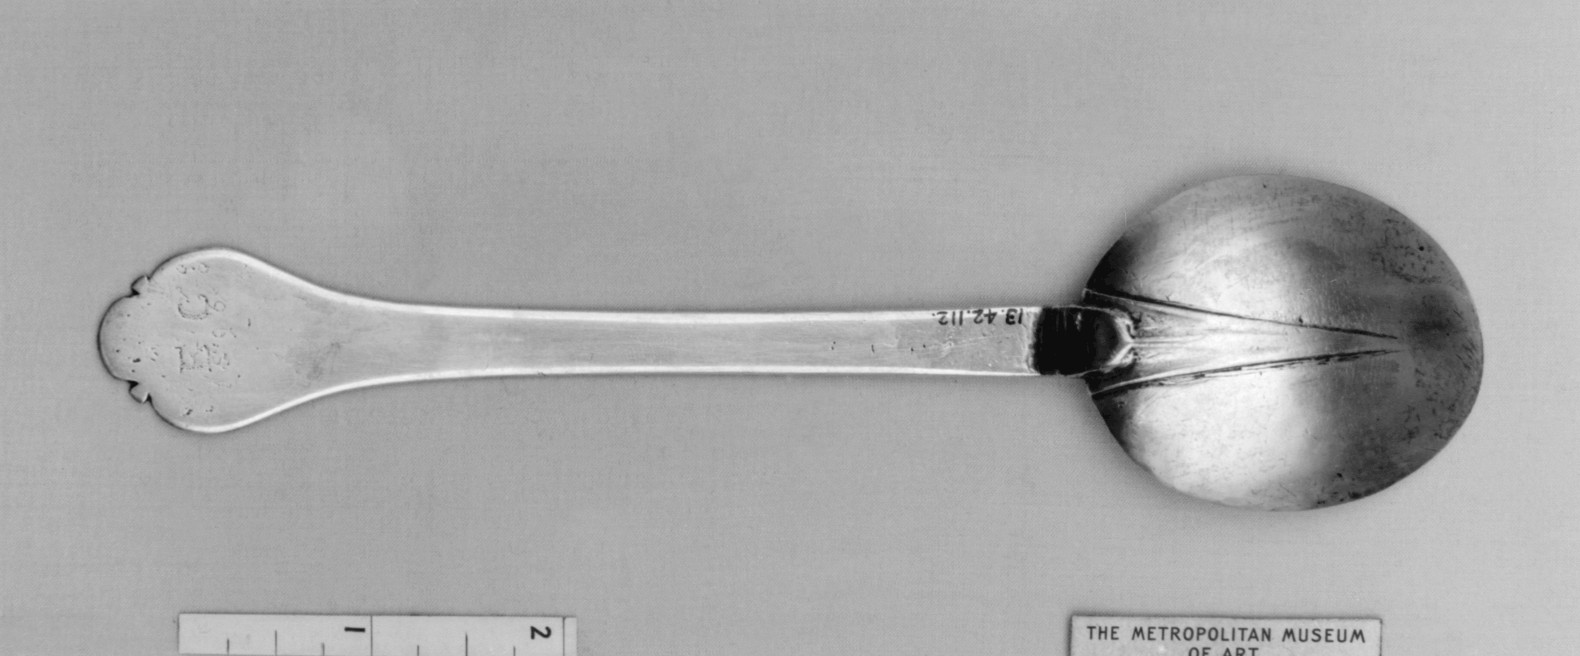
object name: spoon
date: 1667-1700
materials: silver